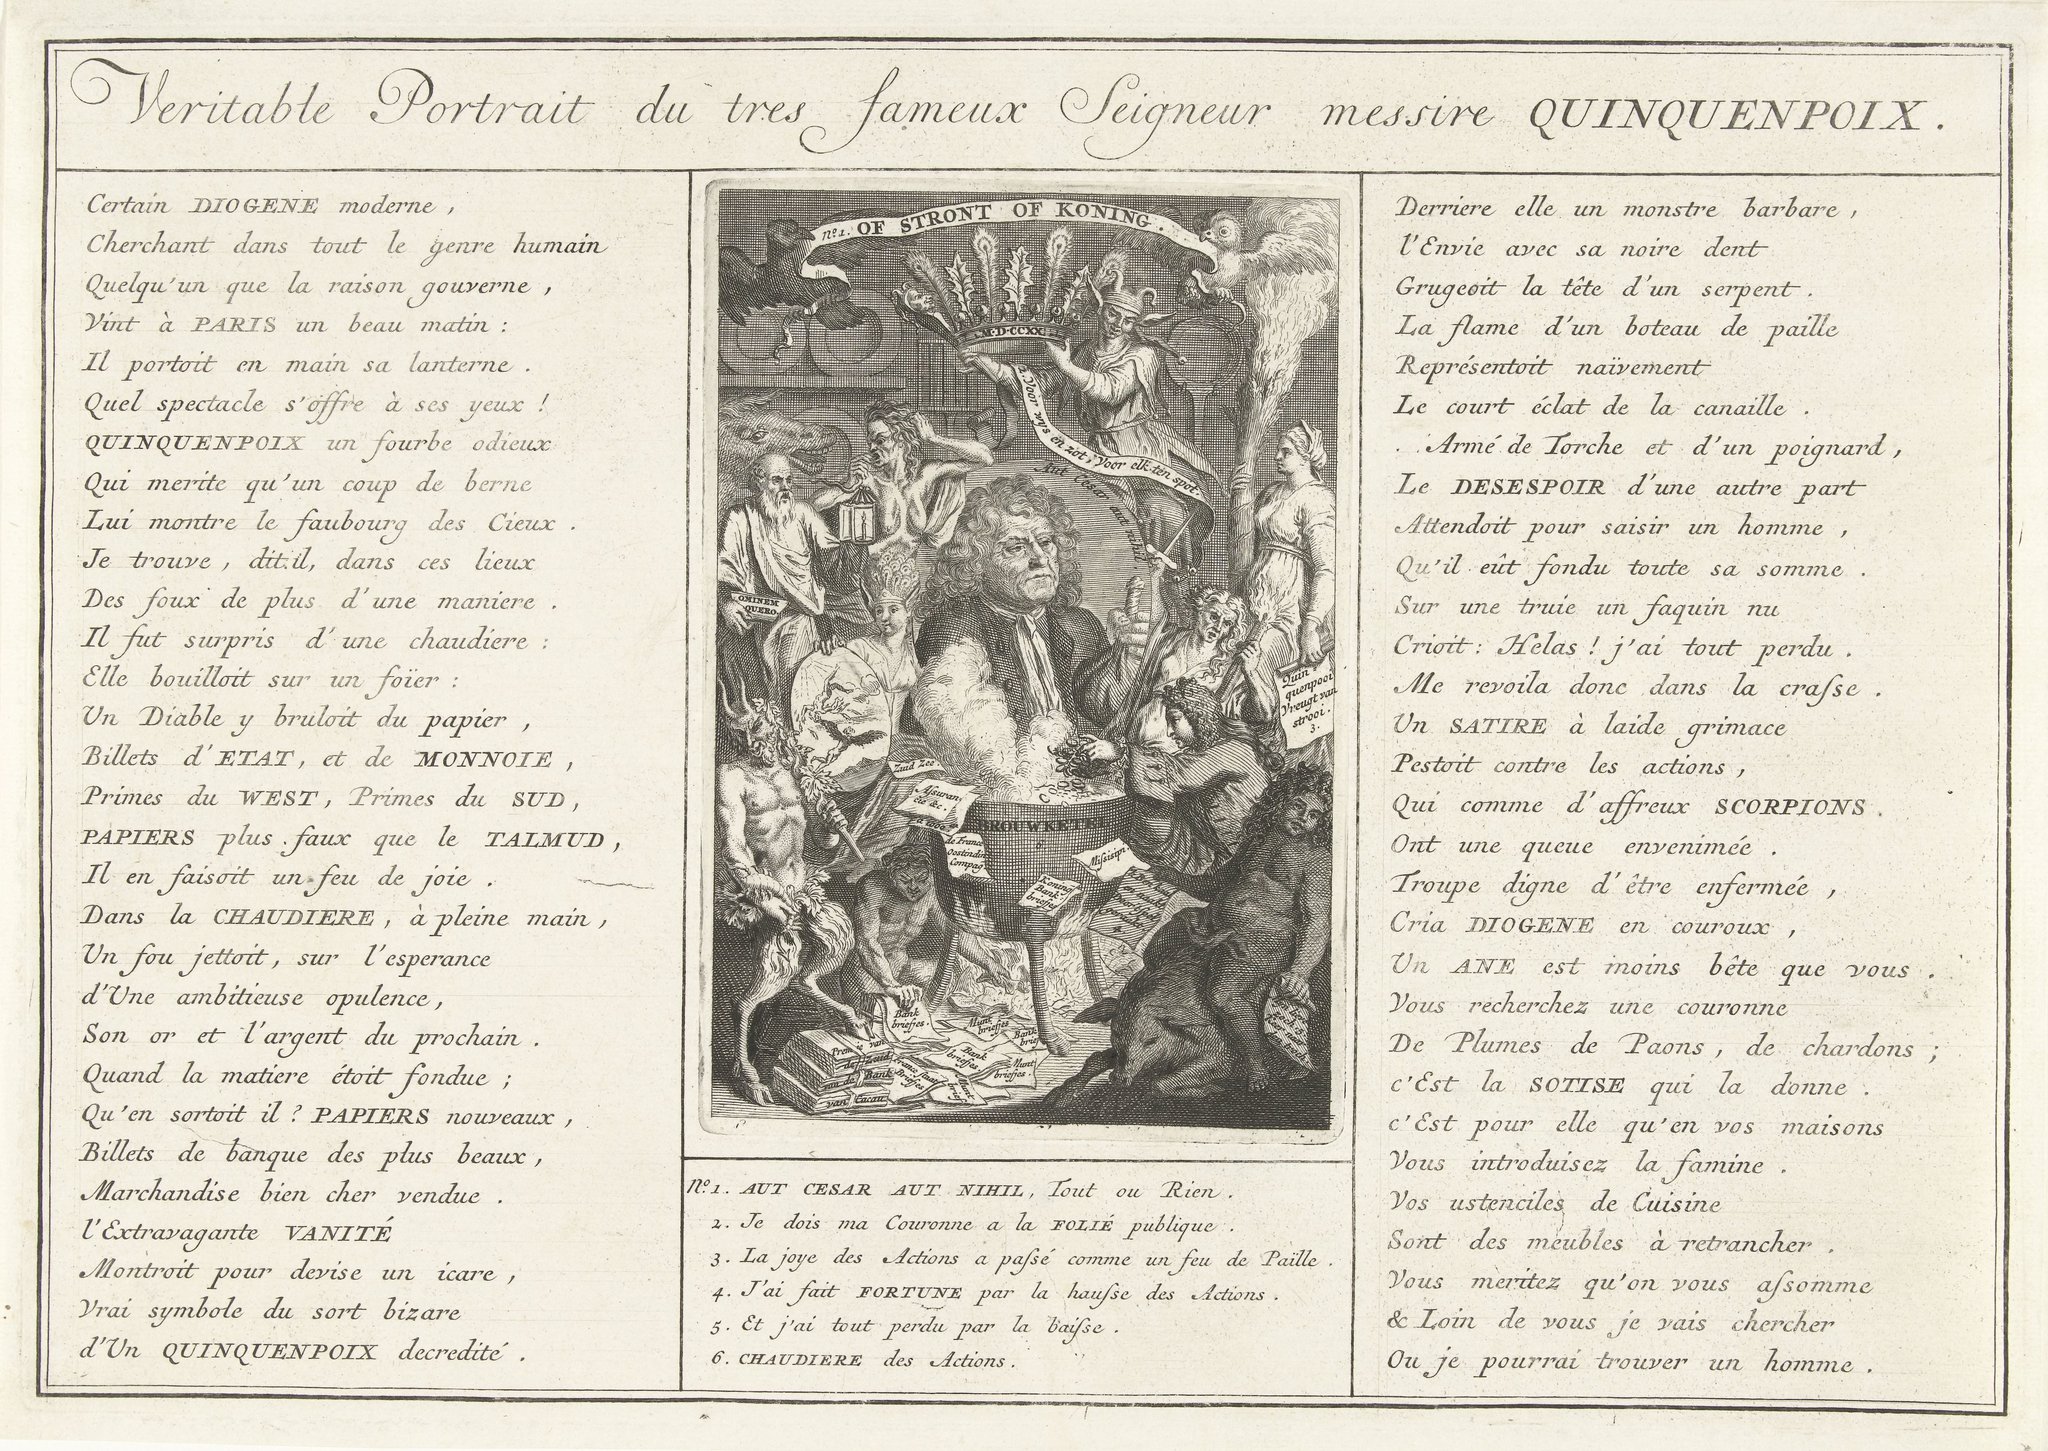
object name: print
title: Het Groote Tafereel der Dwaasheid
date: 1712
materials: paper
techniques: engraving, etching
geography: southern netherlands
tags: brewing, boiling (in a cauldron); witches' kitchen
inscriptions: collector's mark: Lugt 2228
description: Ware afbeelding van de heer Quinquempoix. Portretmedaillon van John Law als de heer Quinquempoix boven een brouwketel waarin geldstukken worden omgetoverd tot aandelen. Heksenketel met duivels, uilen etc. Boven het portret de Zotheid met een kroon van pauwenveren en hulstbladeren. Hierboven een banderol met: No. 1 Of Stront of Koning. Deze plaat afgedrukt binnen een grotere plaat met titel en verzen in het Frans aan weerszijden. Prent 37 in de serie Het Groote Tafereel der Dwaasheid met spotprenten op de Windhandel of Actiehandel van 1720.